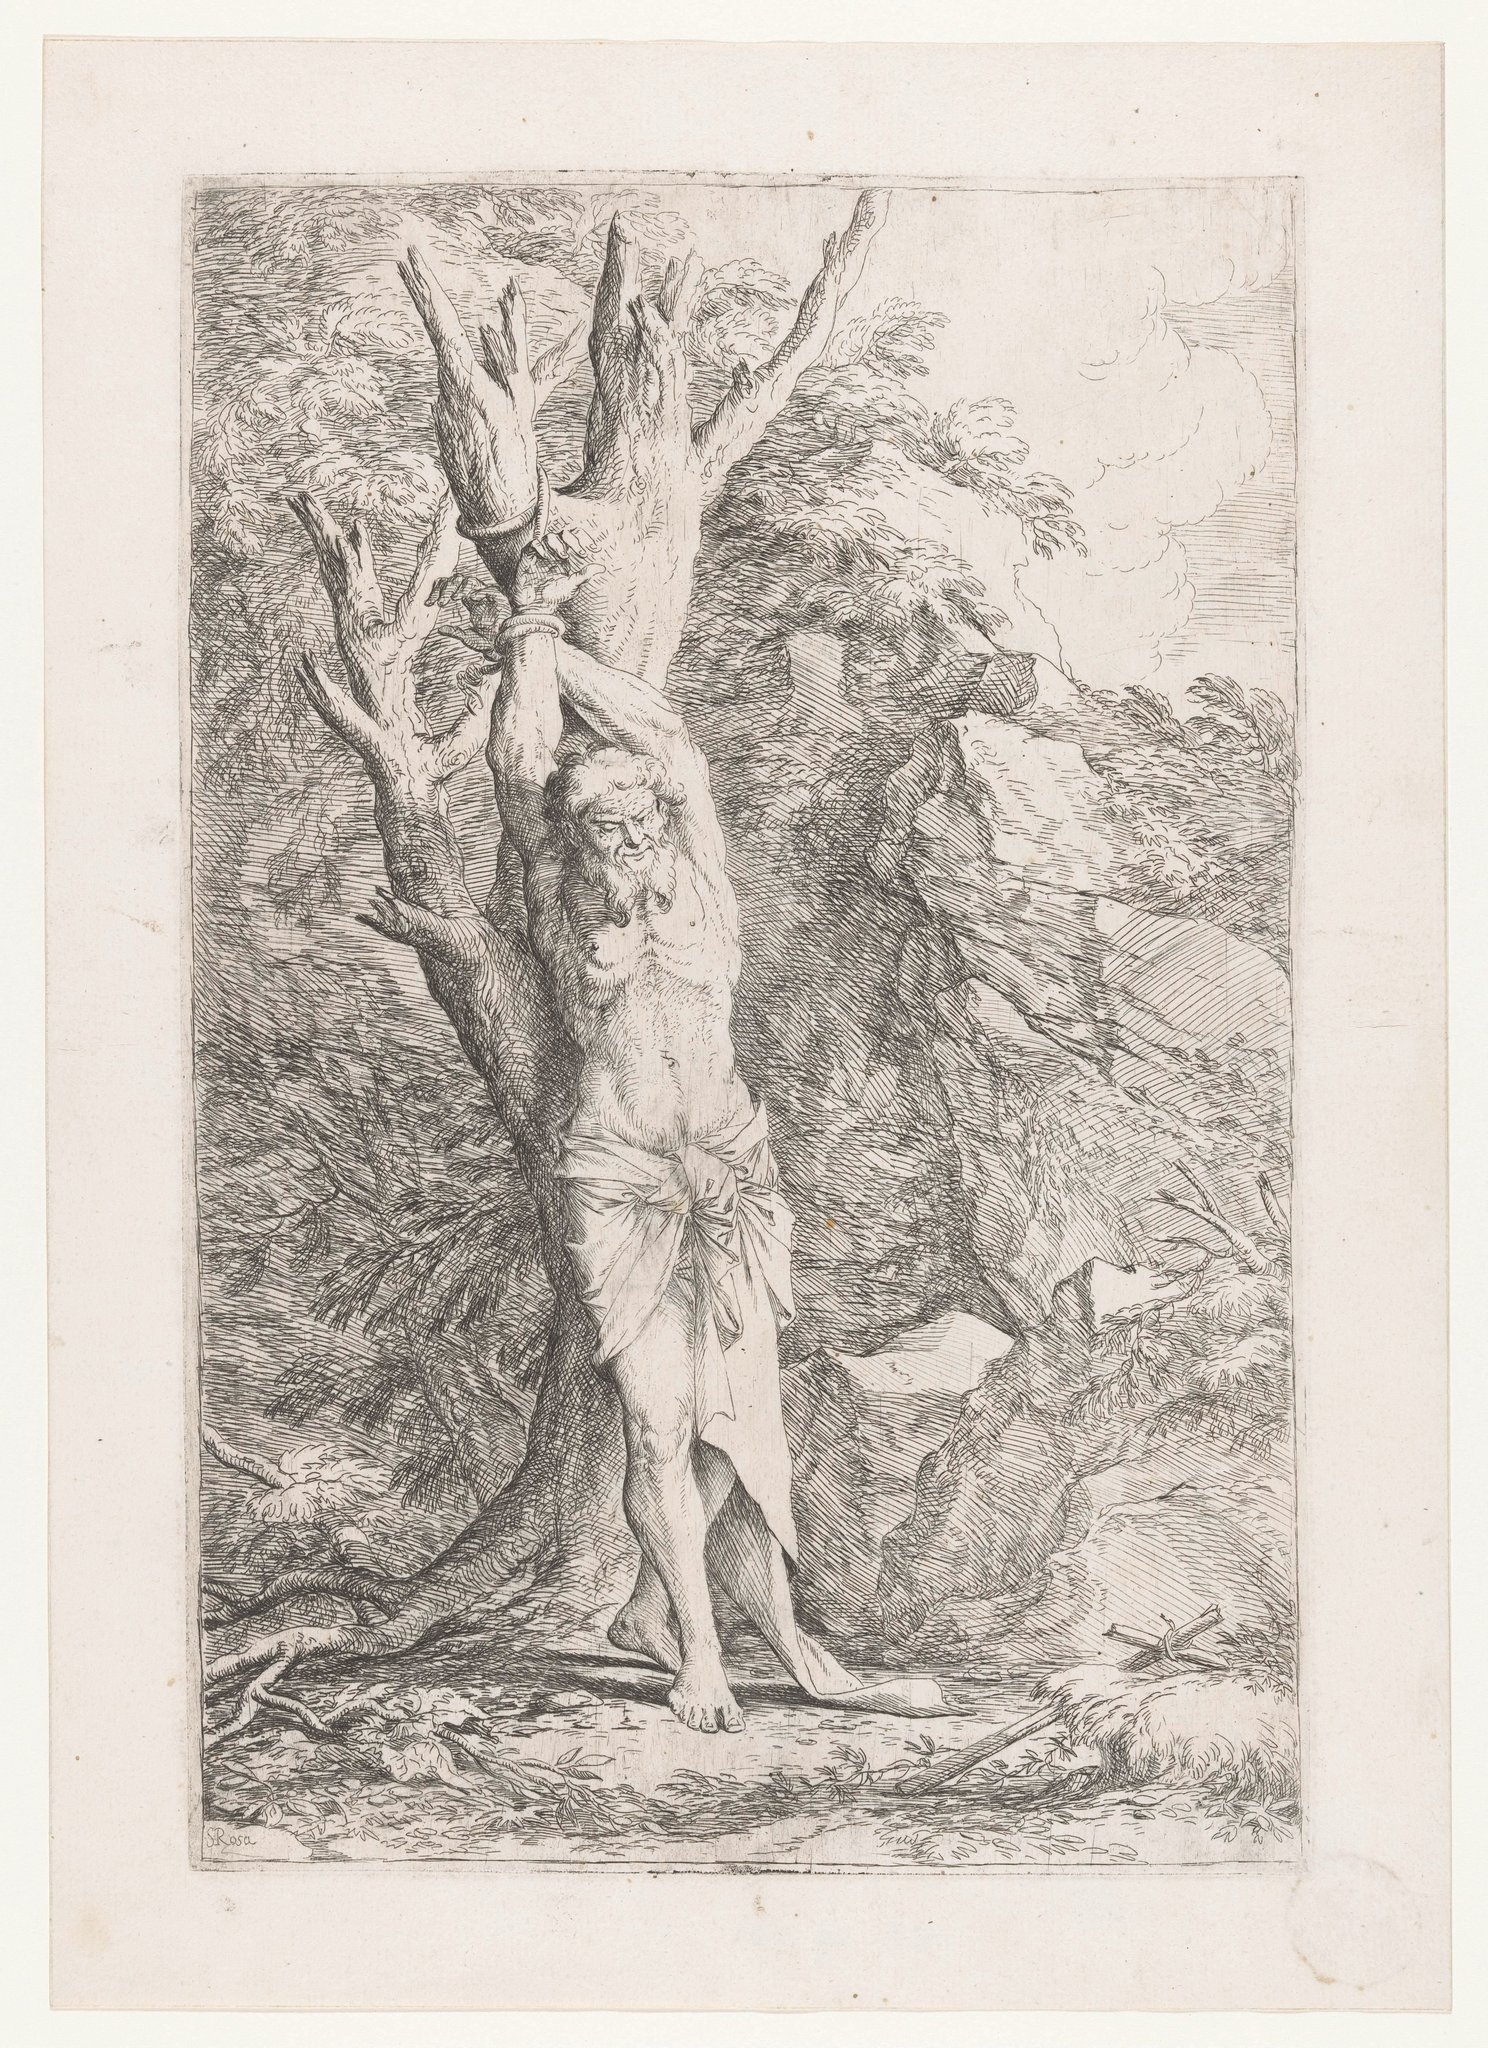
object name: print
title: Albert vastgebonden aan een boom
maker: salvator rosa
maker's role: draughtsman, painter, print maker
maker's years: 1615-1673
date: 1661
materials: paper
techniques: drypoint, etching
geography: italy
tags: trees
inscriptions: collector's mark: Lugt 240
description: Albert, de metgezel van de heilige Willem van Maleval, vastgebonden aan een boom. Rechts op de voorgrond ligt een kruis.